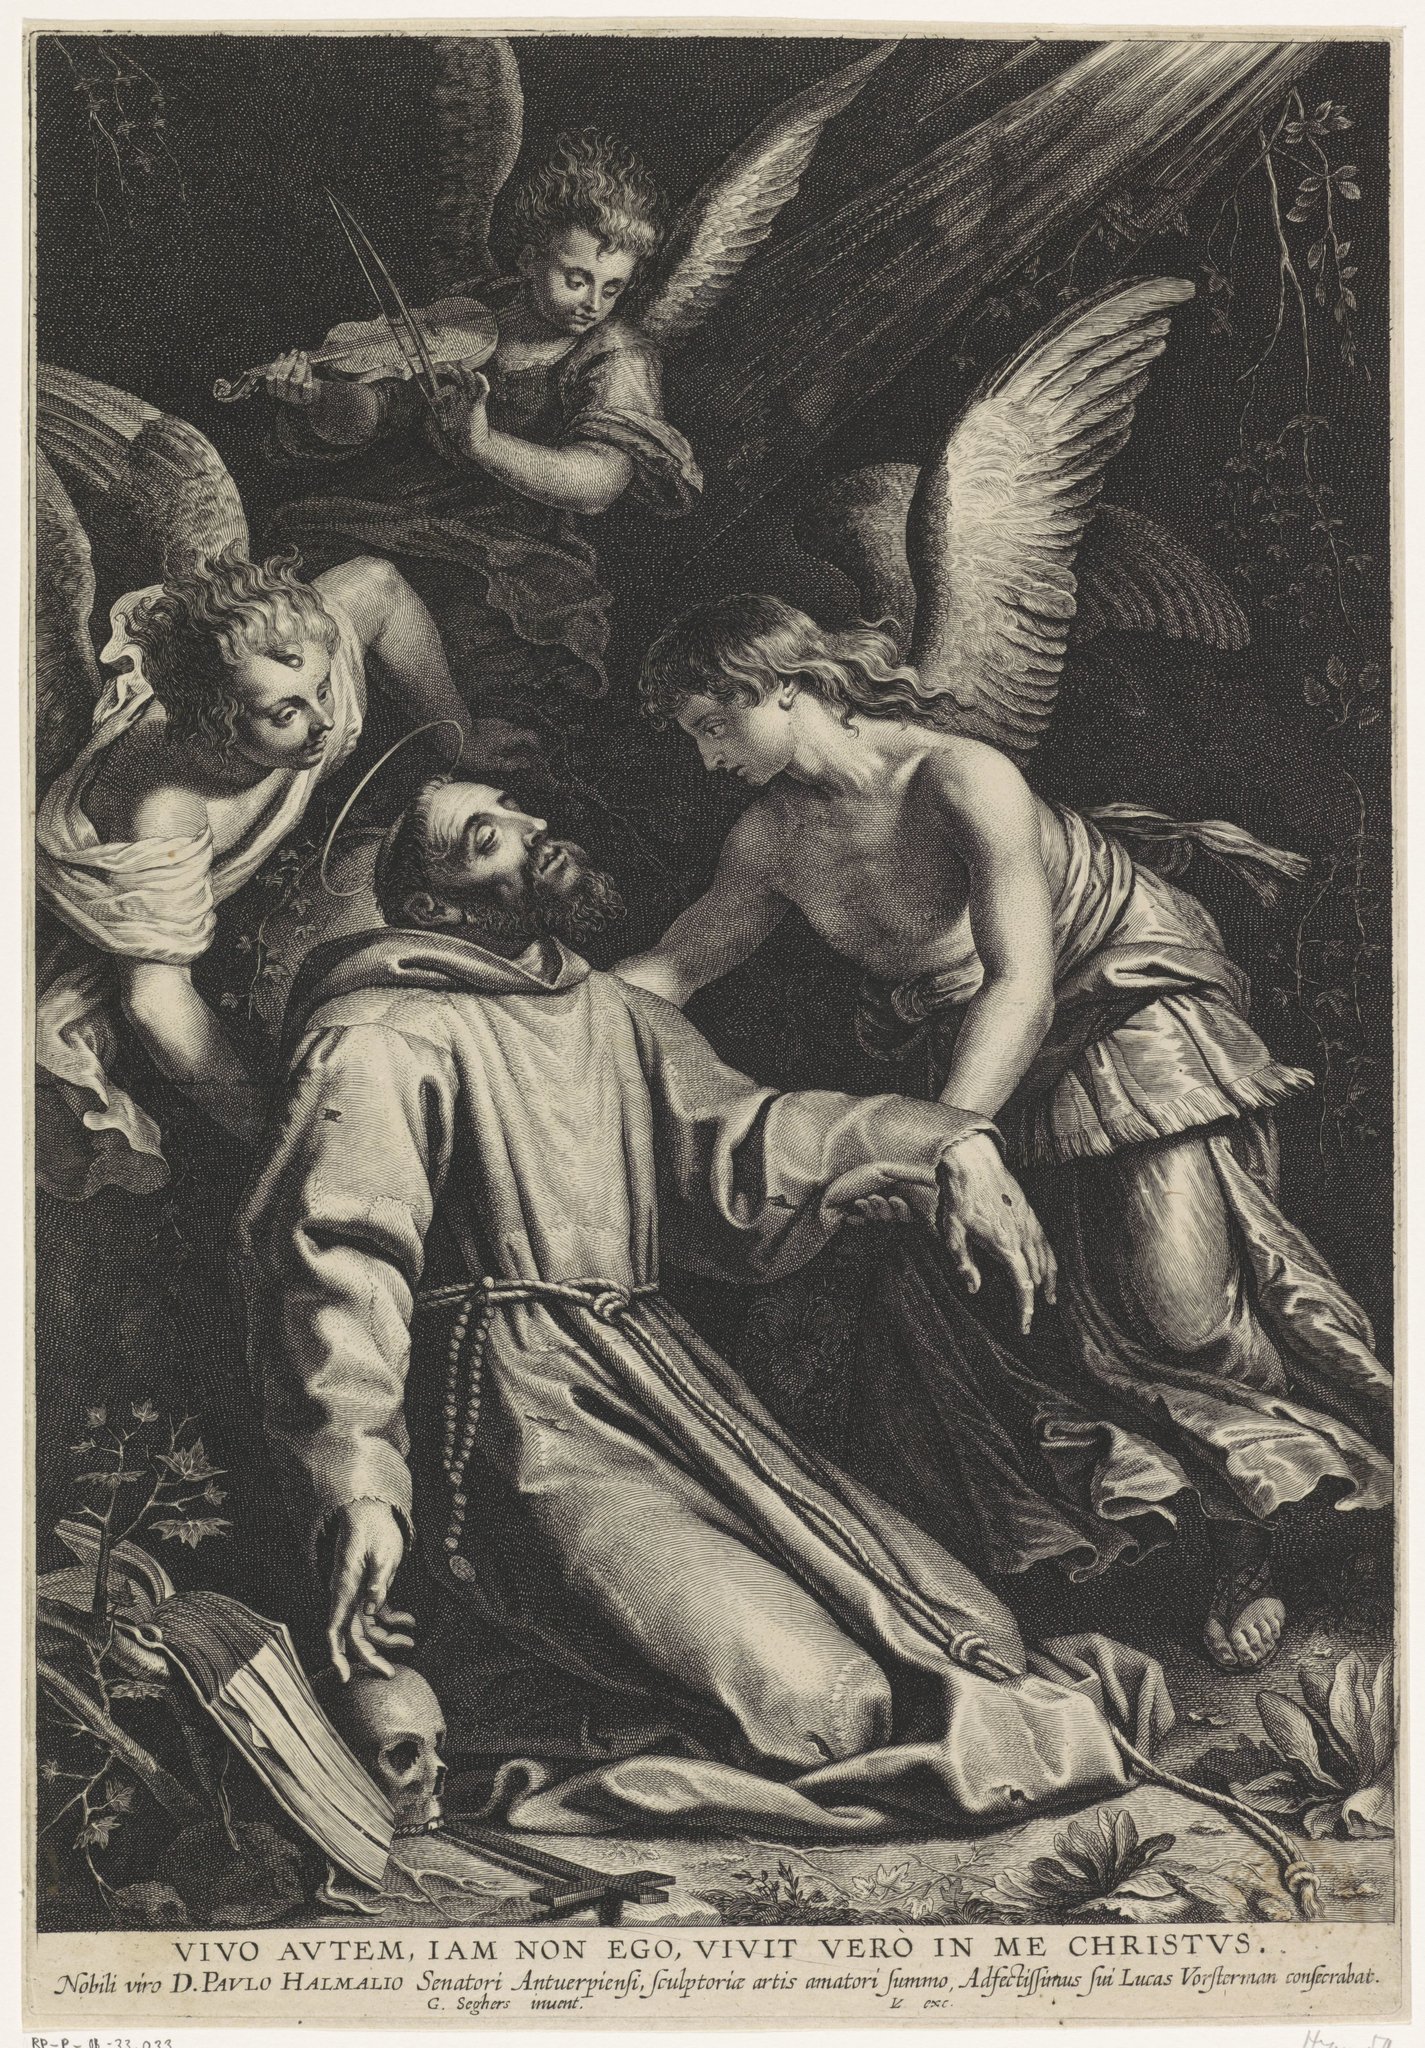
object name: print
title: H. Franciscus van Assisi ondersteund door engelen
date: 1619-1643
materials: paper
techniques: engraving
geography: antwerp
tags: st. francis of assisi in ecstasy (+ angel(s))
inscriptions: collector's mark: Lugt 240